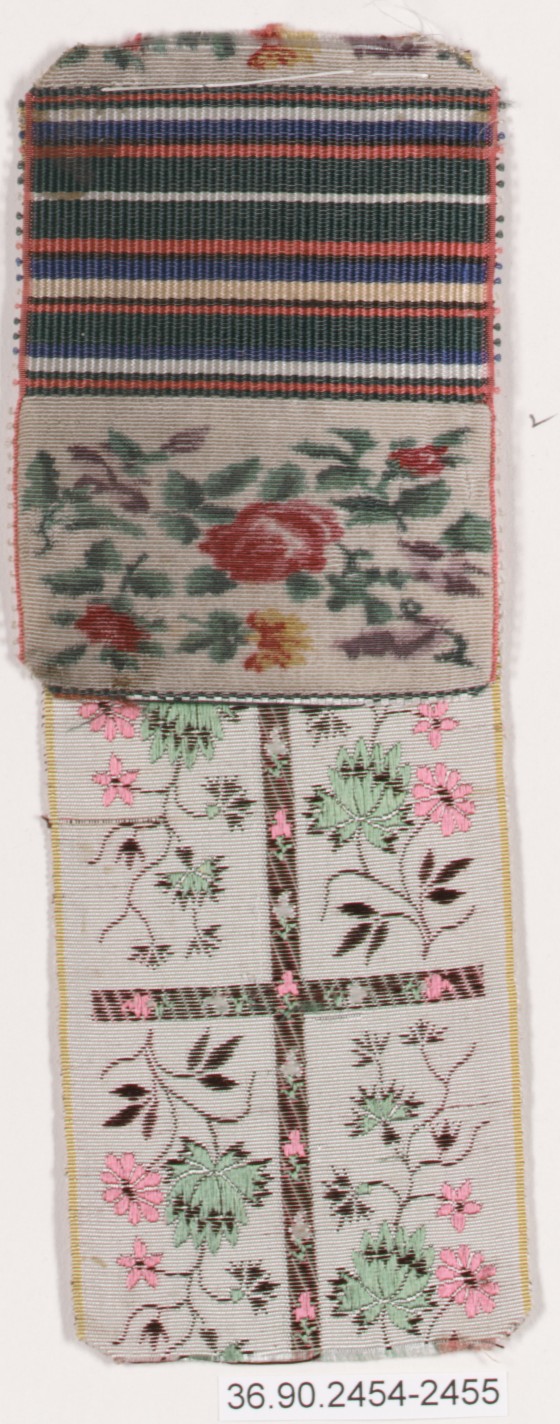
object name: ribbon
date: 1801-1900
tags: flowers